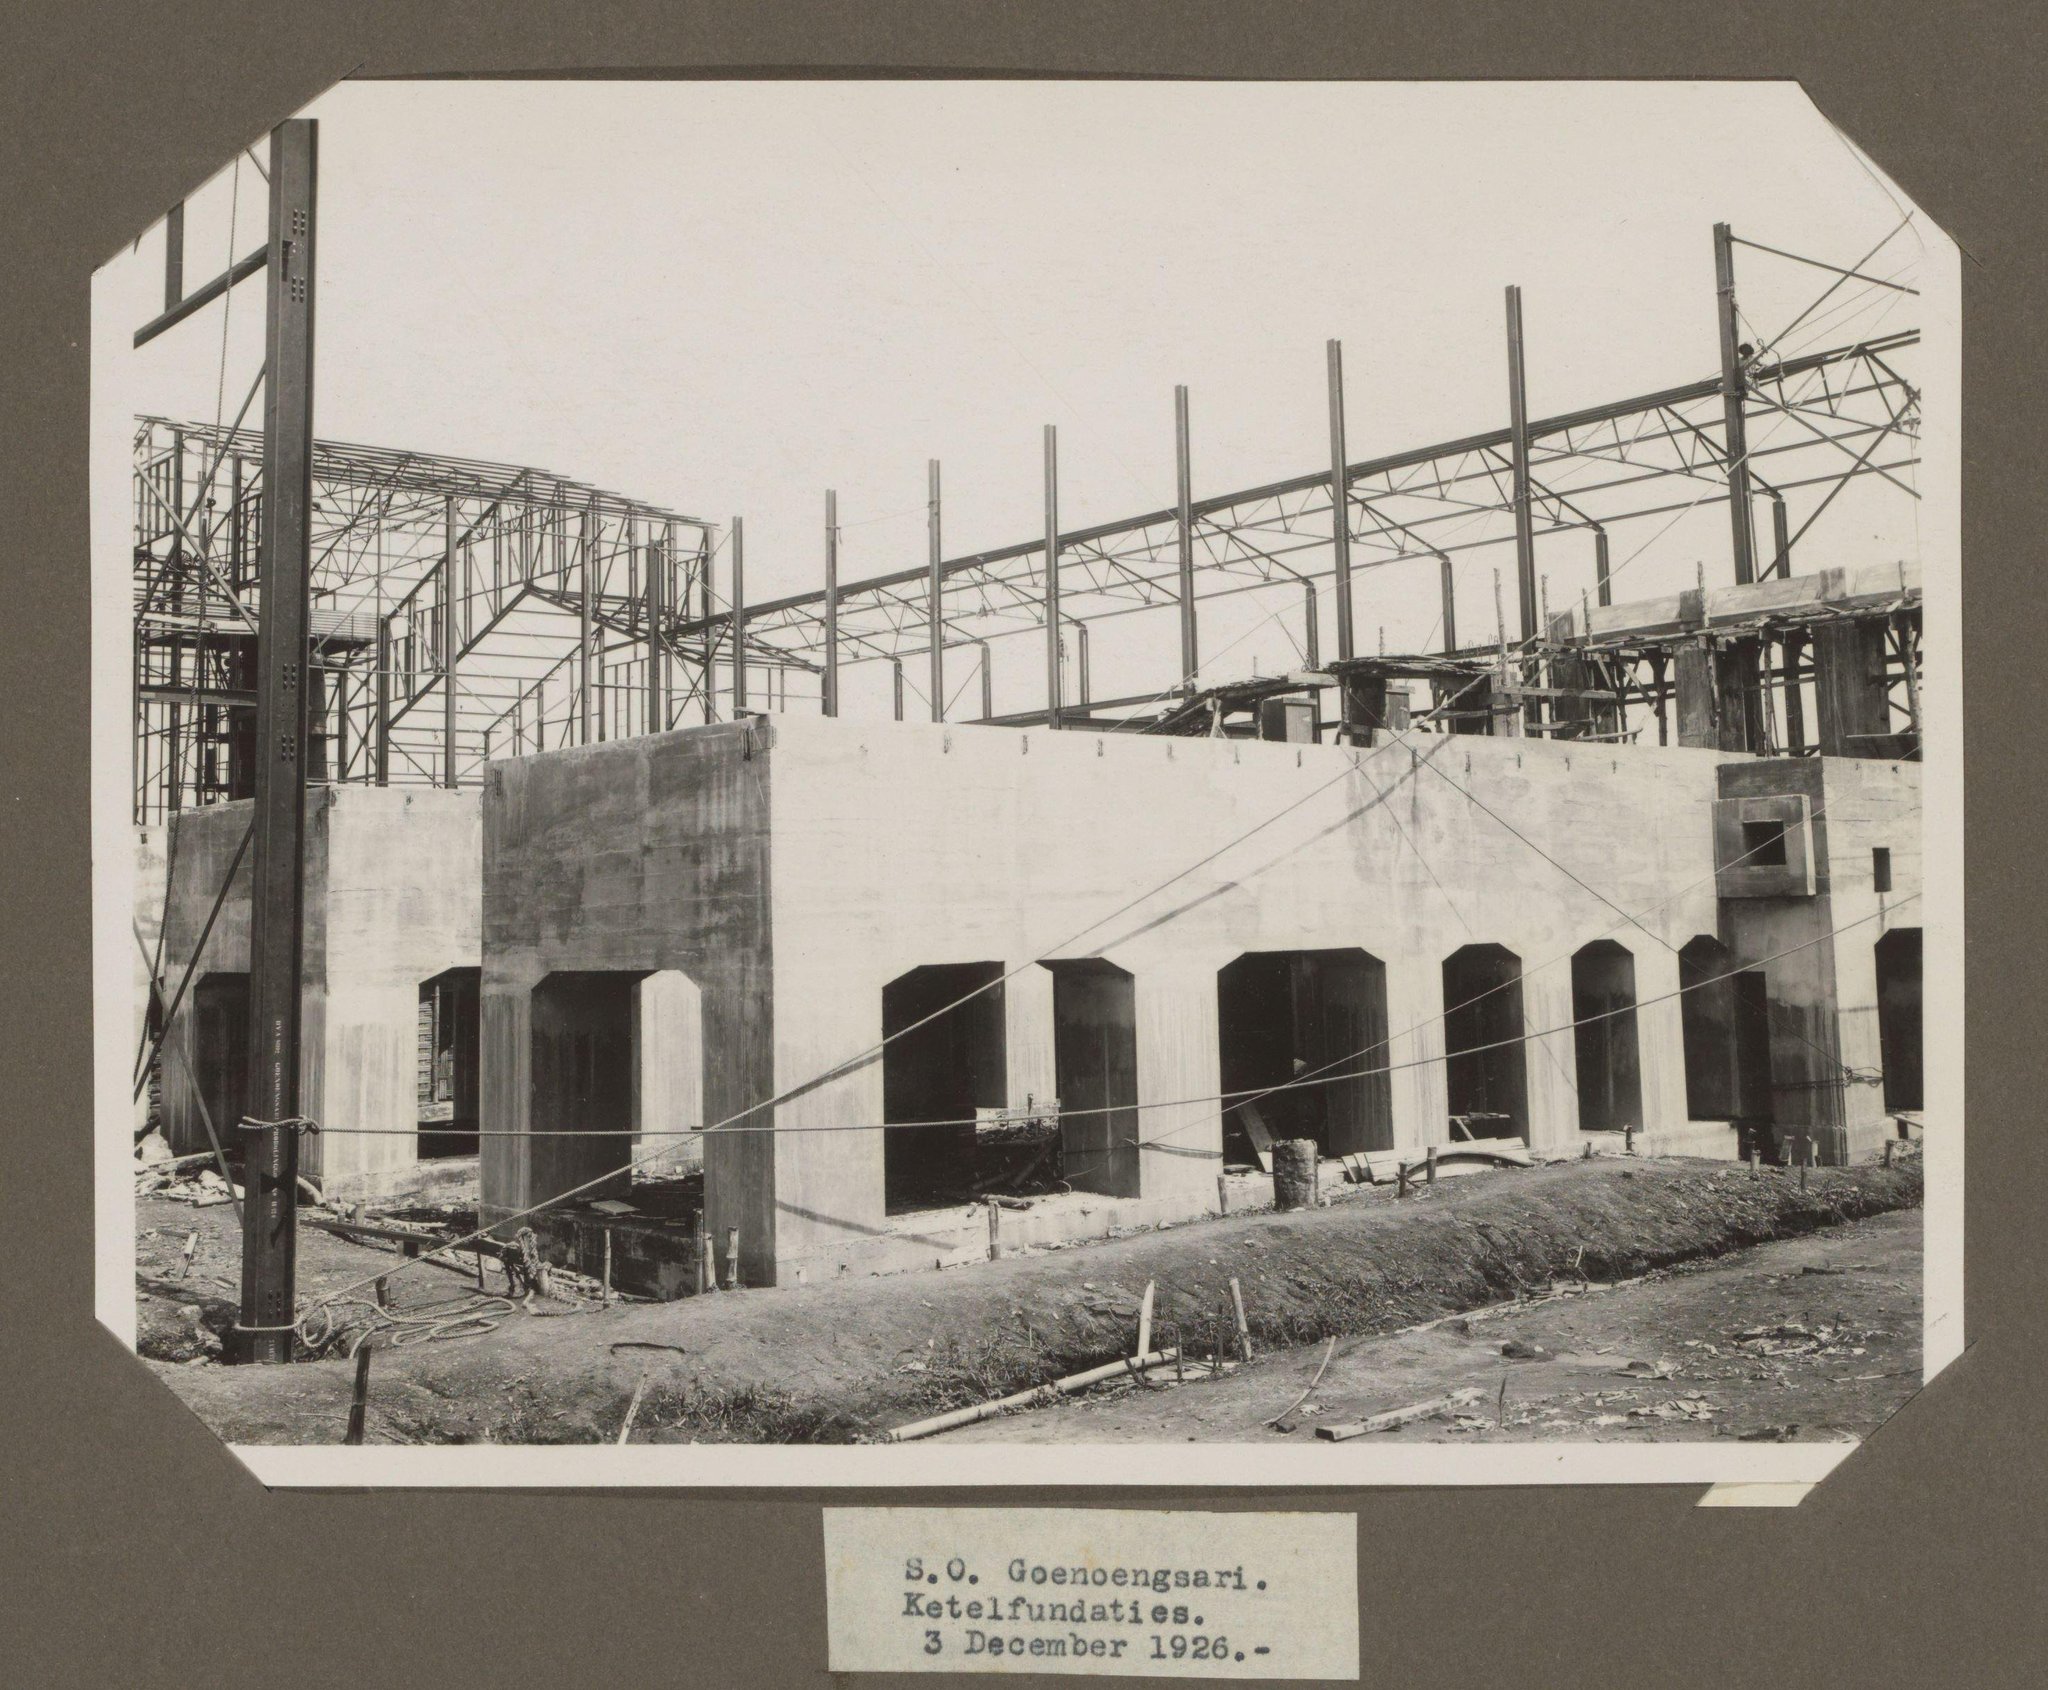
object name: photograph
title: S.O. Goenoengsari. Ketelfundaties. 3 December 1926.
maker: Anonymous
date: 1912-1926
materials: photographic support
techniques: gelatin silver print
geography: east java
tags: colonial system, trade-company, making the overground structures (~ building activities), industrial structures, (non-fruit) products of plants or trees: sugarcane, representation of real building (either existing or having existed)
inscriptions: inscription: ‘S.O. Goenoengsari. Ketelfundaties. 3 December 1926.’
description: De fundamenten van gewapend beton voor het ketelstation, 3 december 1926. Onderdeel van het fotoalbum met foto's van de opbouw van de suikerfabriek te Goenoengsari op Oost-Java door de Handels Vereniging Amsterdam 1926-1927.